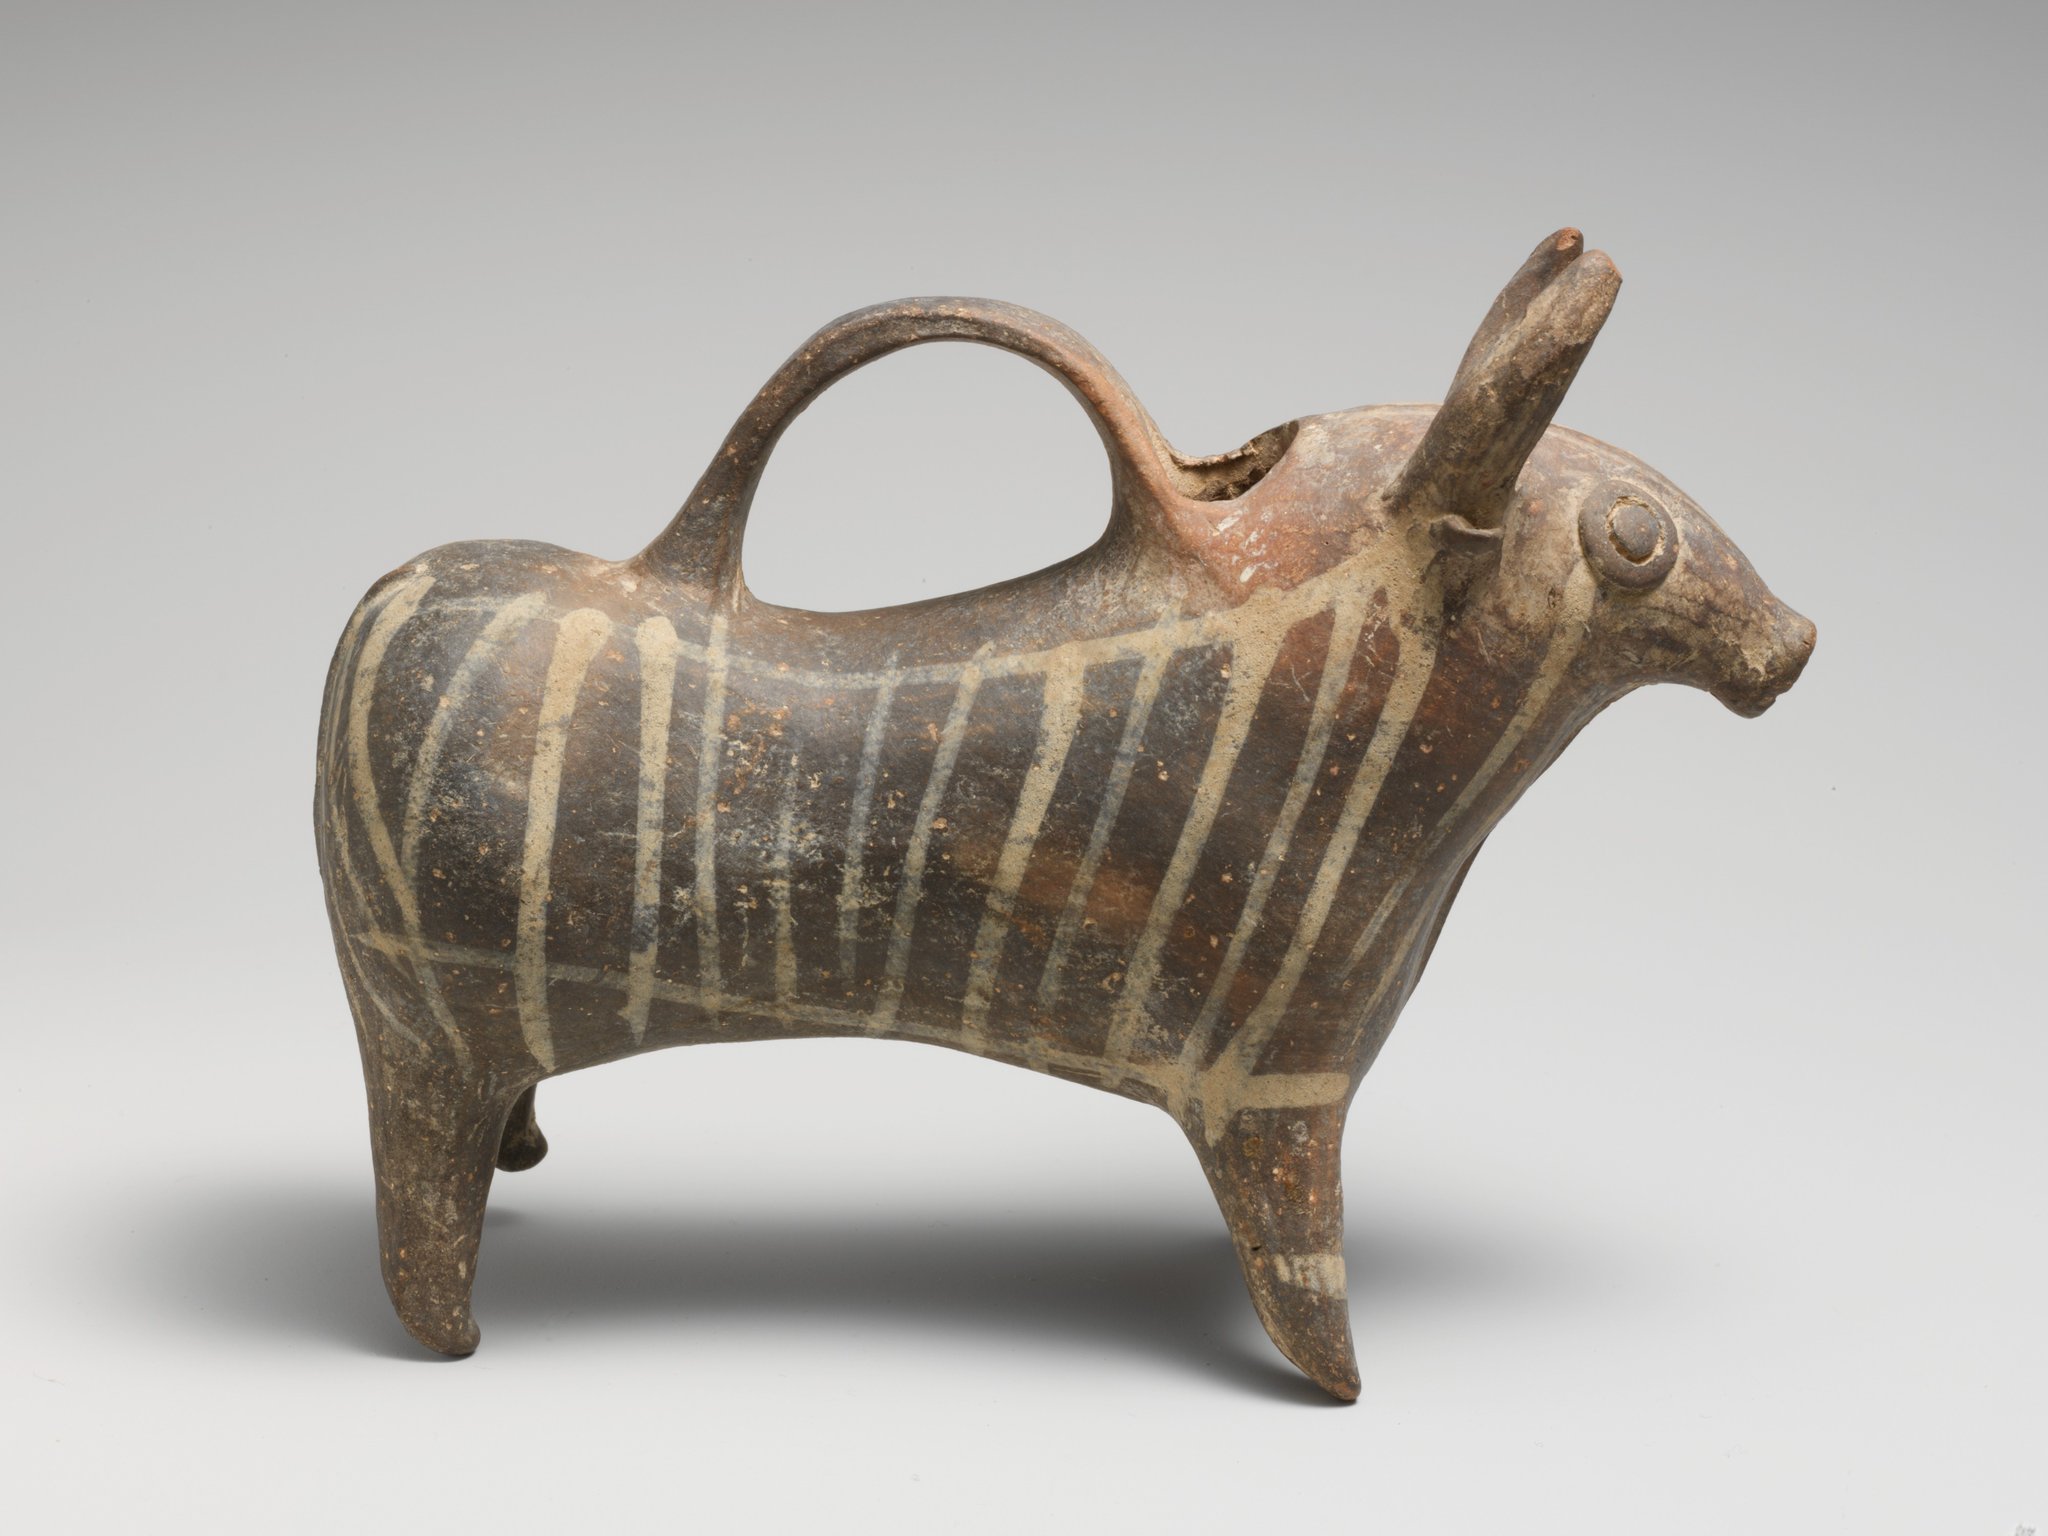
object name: vase in the form of a bull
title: Terracotta vase in the form of a bull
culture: cypriot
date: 1600-1050 BCE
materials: terracotta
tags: bulls